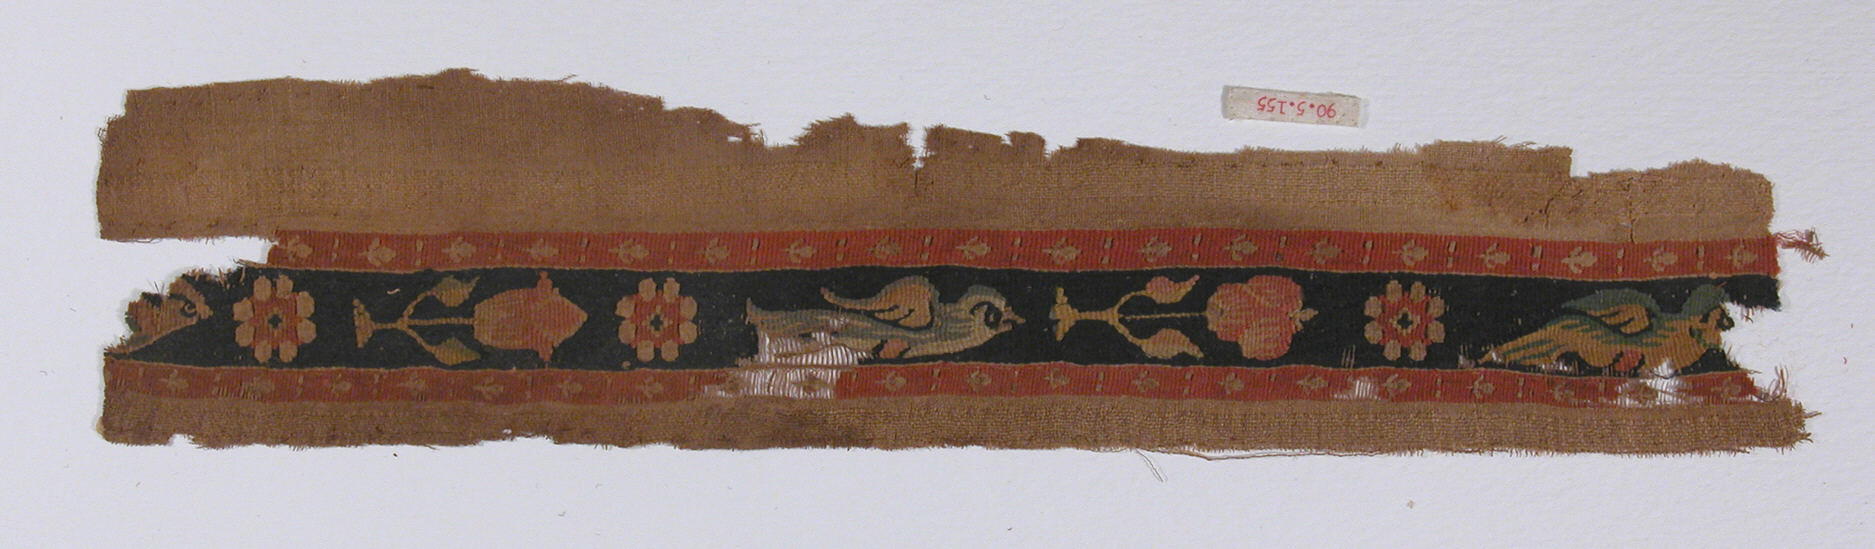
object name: textile fragment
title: Fragment with a Band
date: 301-400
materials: linen, wool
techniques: weave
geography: egypt